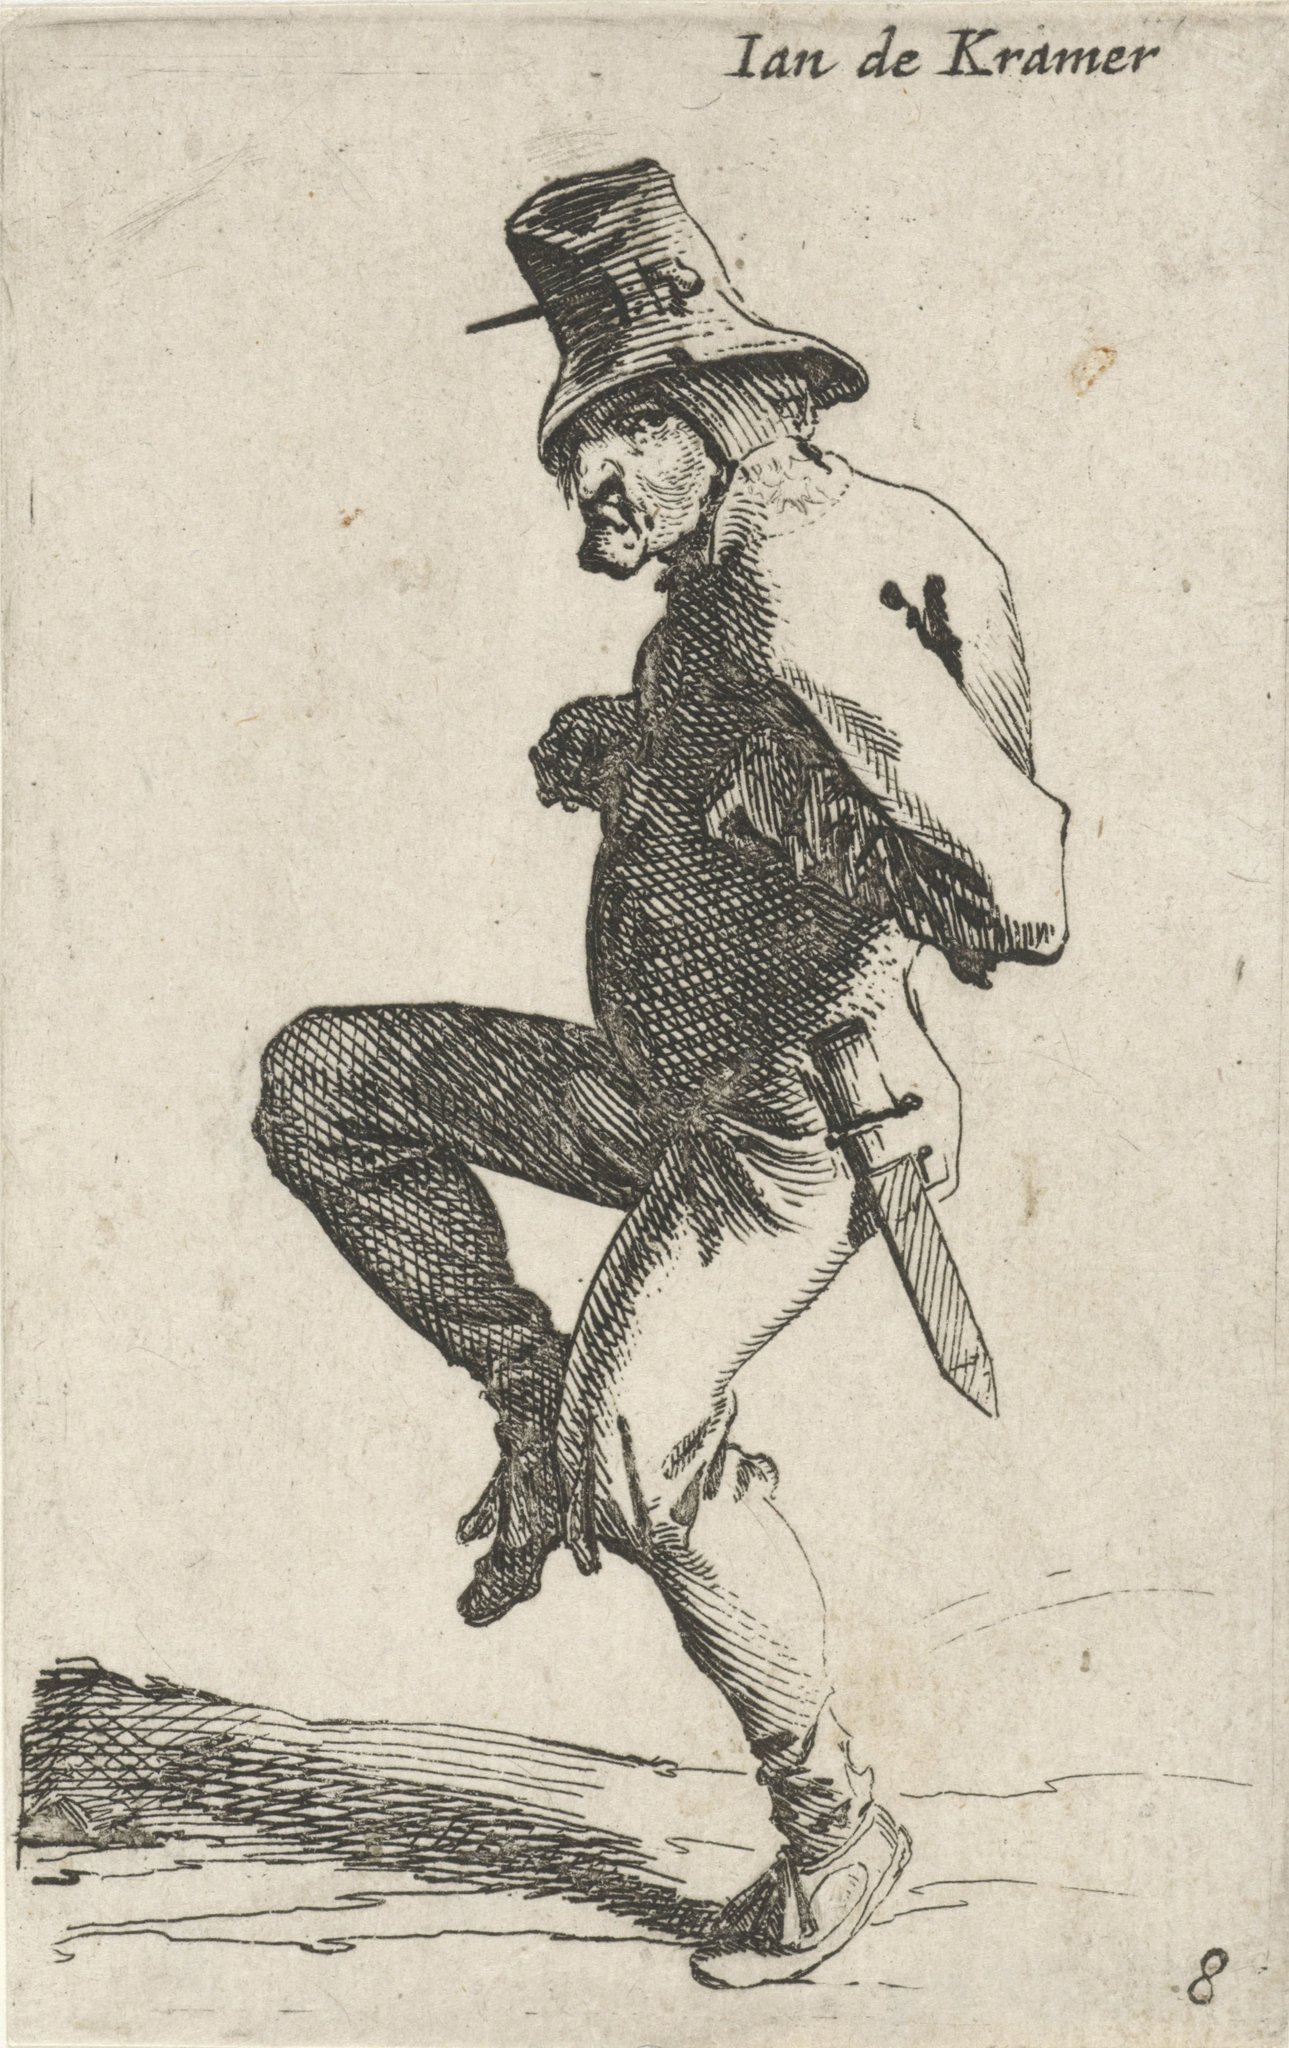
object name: print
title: Dansende man met mes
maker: salomon savery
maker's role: print maker, publisher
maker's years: 1594-1683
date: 1630-1665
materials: paper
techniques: engraving, etching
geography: amsterdam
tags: hacking and thrusting weapons: dagger, man dancing alone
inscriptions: collector's mark: Lugt 240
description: De prent maakt deel uit van een twaalfdelige serie prenten met voorstellingen van boeren.